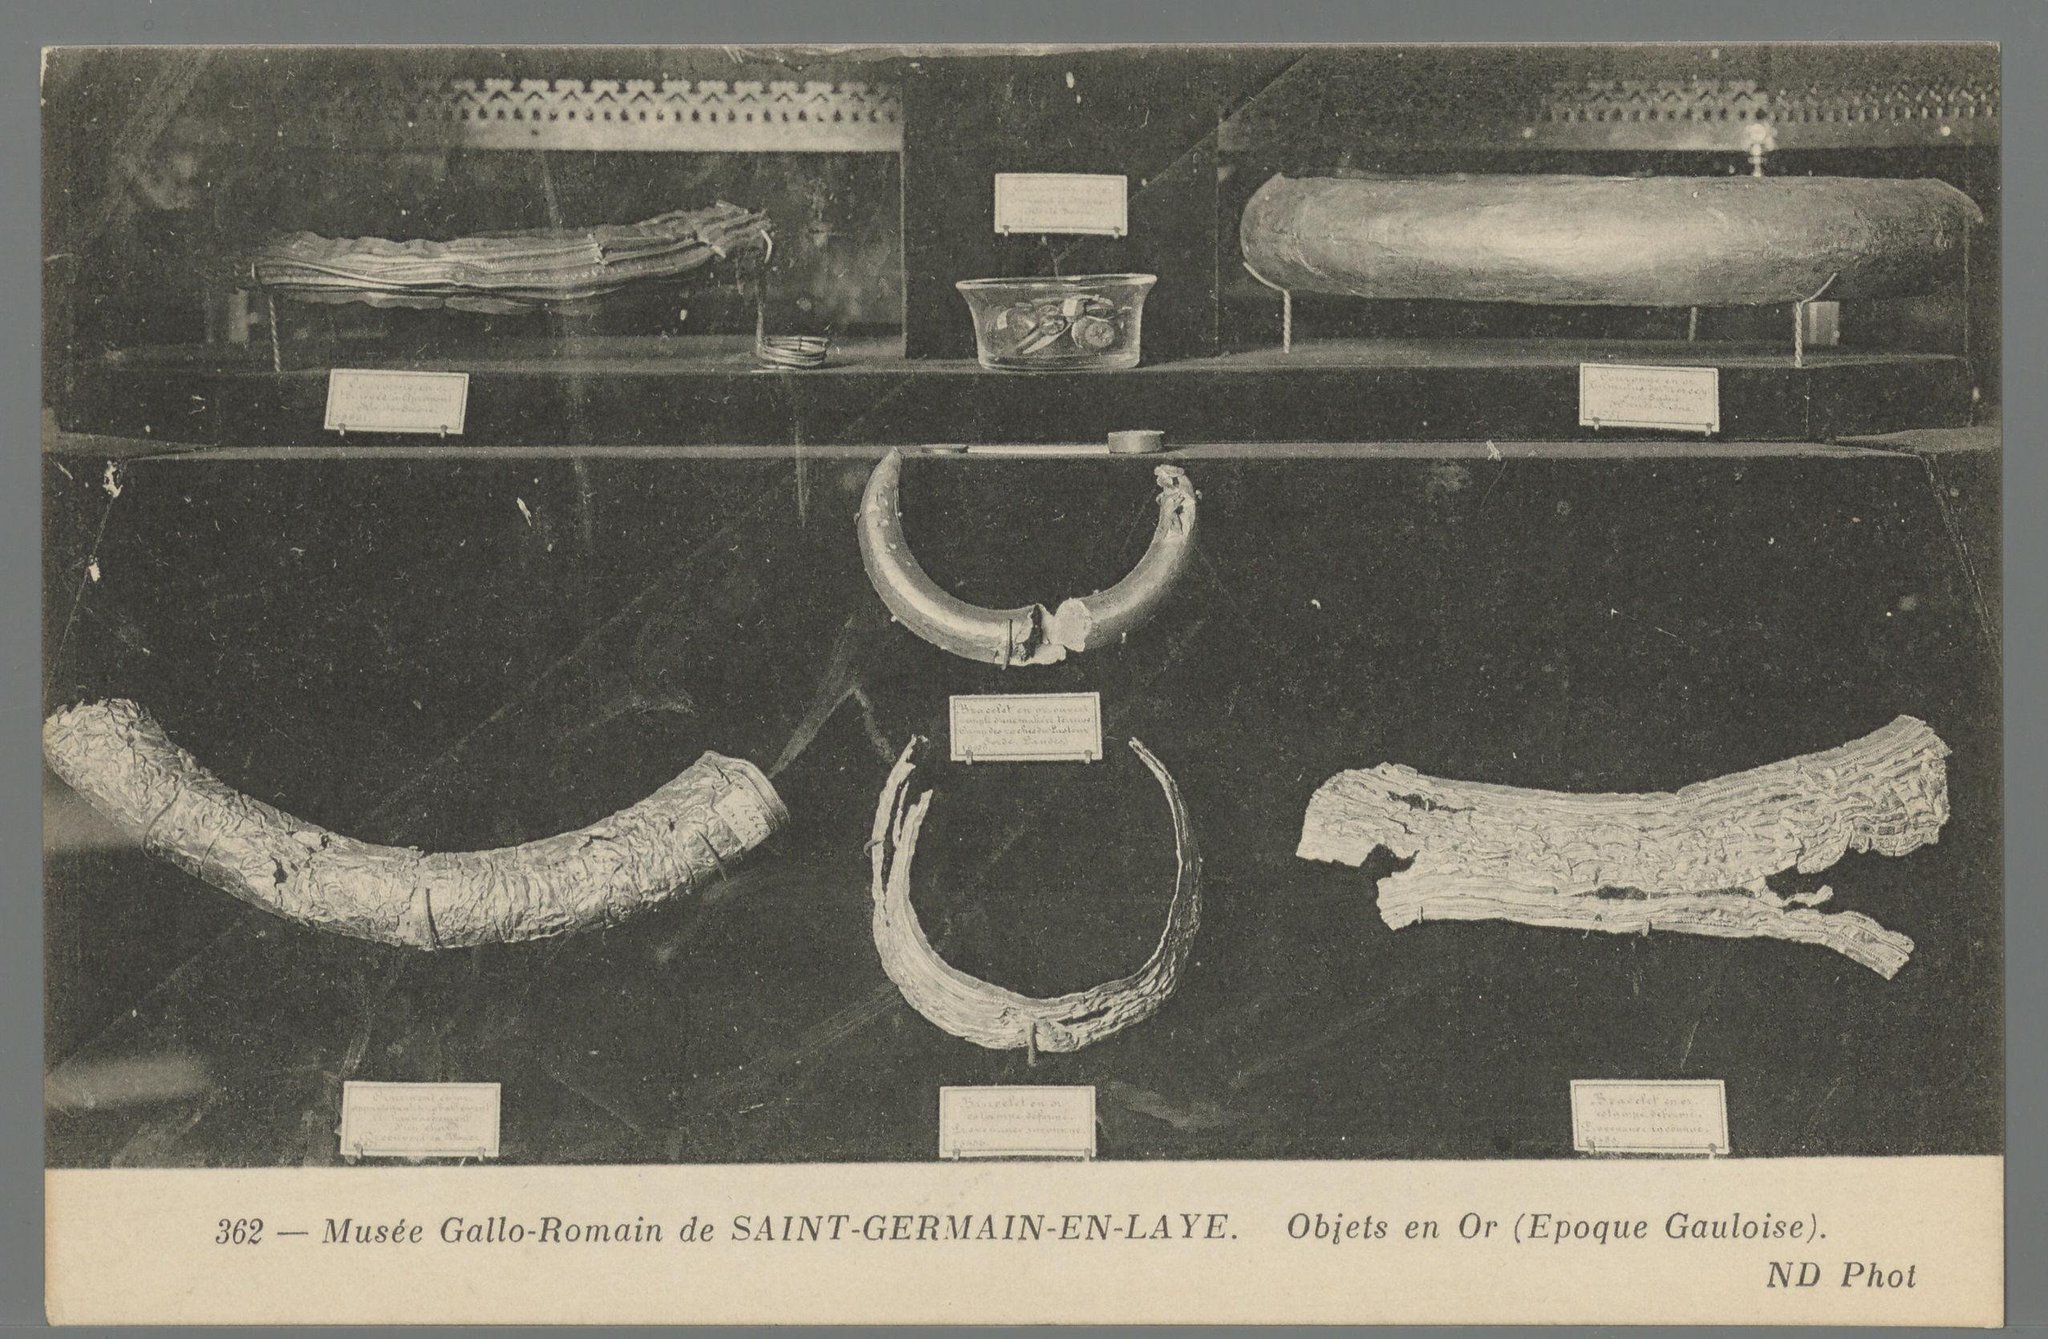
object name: photomechanical print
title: Musée Gallo-Romain de Saint-Germain-en-Laye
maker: Anonymous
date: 1903-1918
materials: cardboard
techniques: photograph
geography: paris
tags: ornaments, jewels, permanent exhibition, museum, minerals and metals: gold